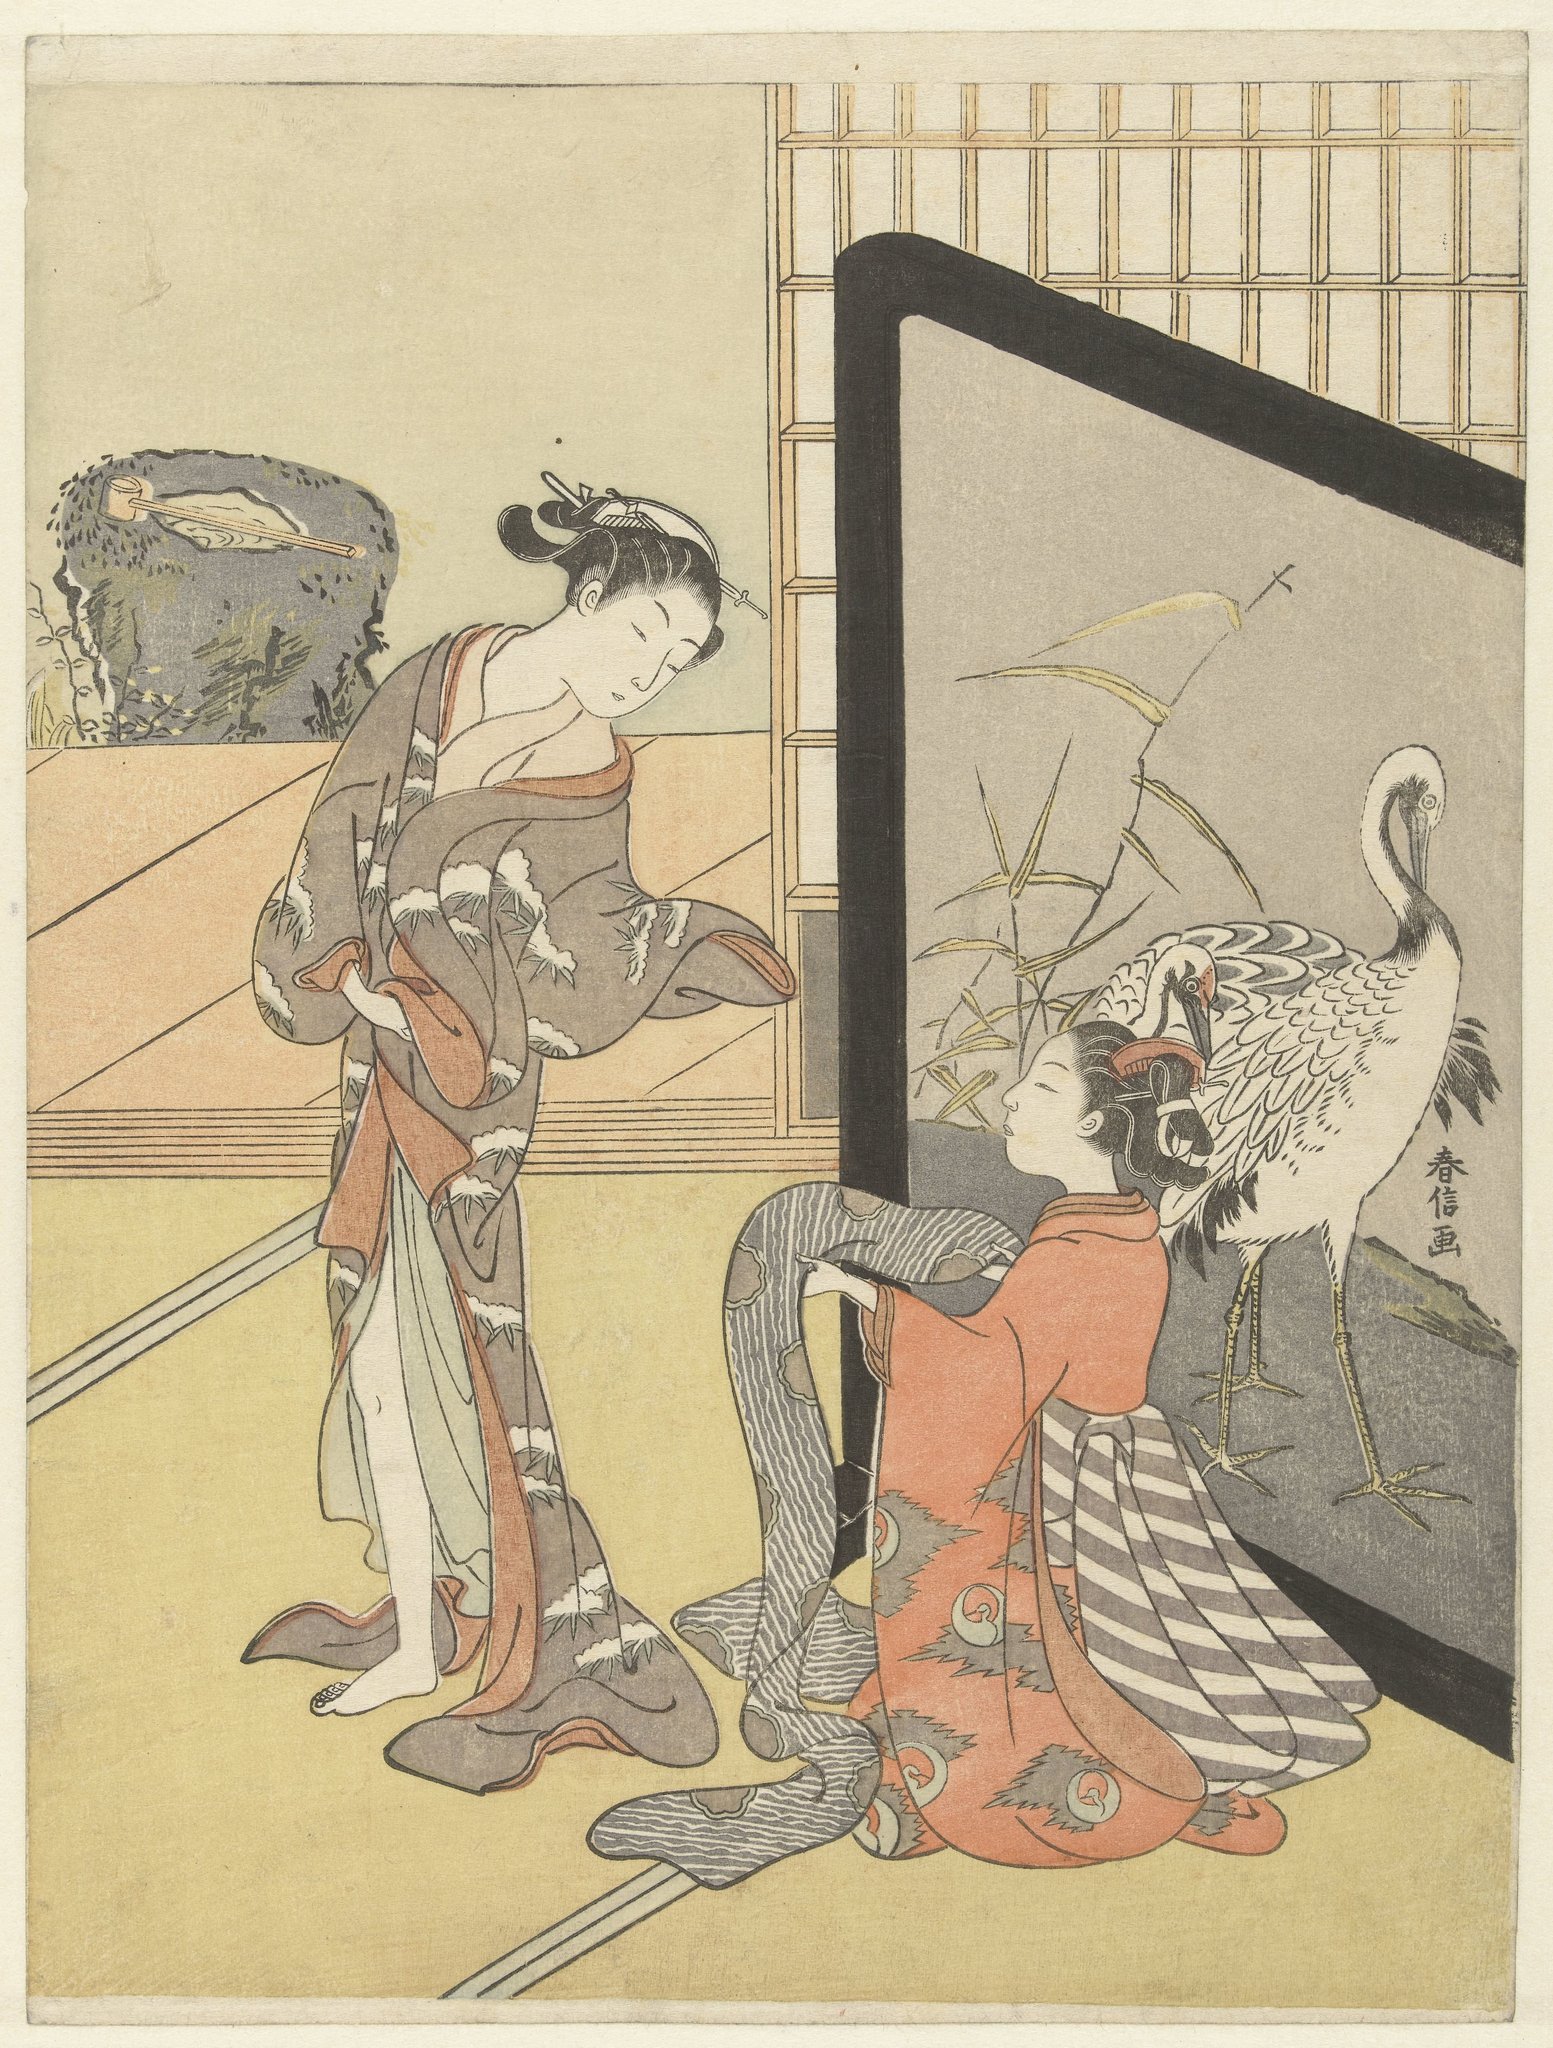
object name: print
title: Het kiezen van een obi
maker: suzuki harunobu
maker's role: print maker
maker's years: 1725-1770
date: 1765-1770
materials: paper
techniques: woodcut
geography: japan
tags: shore-birds and wading-birds: crane, fashion, clothing, screen, folding screen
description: Vrouw, staand in kimono met patroon van besneeuwde bamboe, kijkend naar obi welke haar wordt getoond door een vrouw zittend naast kamerscherm waarop afbeelding van twee kraanvogels. Op de achtergrond een gezicht op veranda en waterbekken.